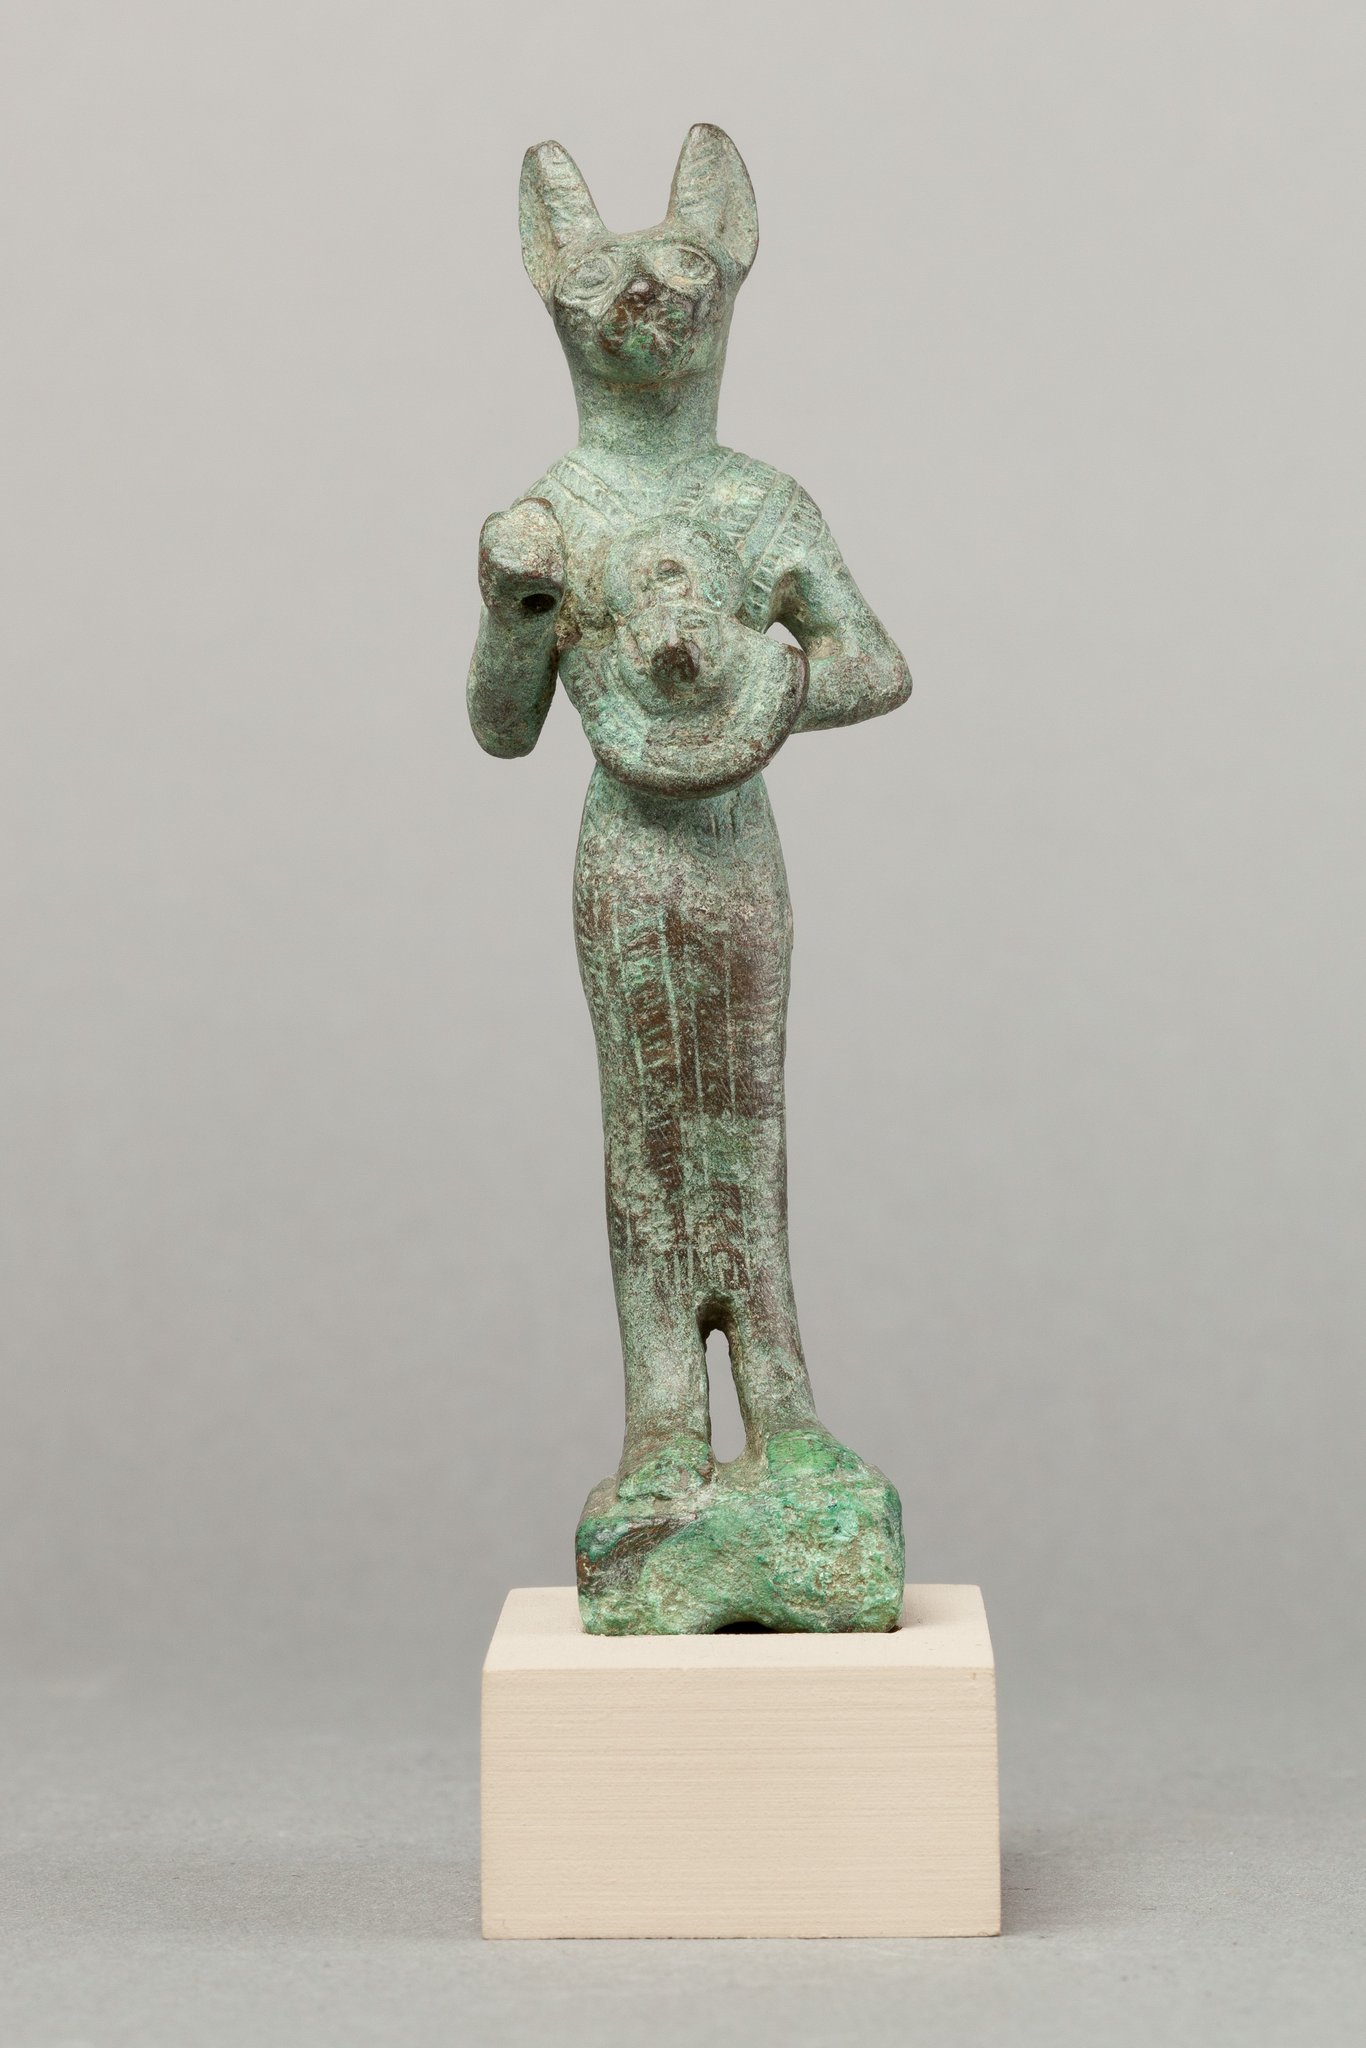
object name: statuette, bastet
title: Bastet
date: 664-630 BCE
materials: metal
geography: egypt